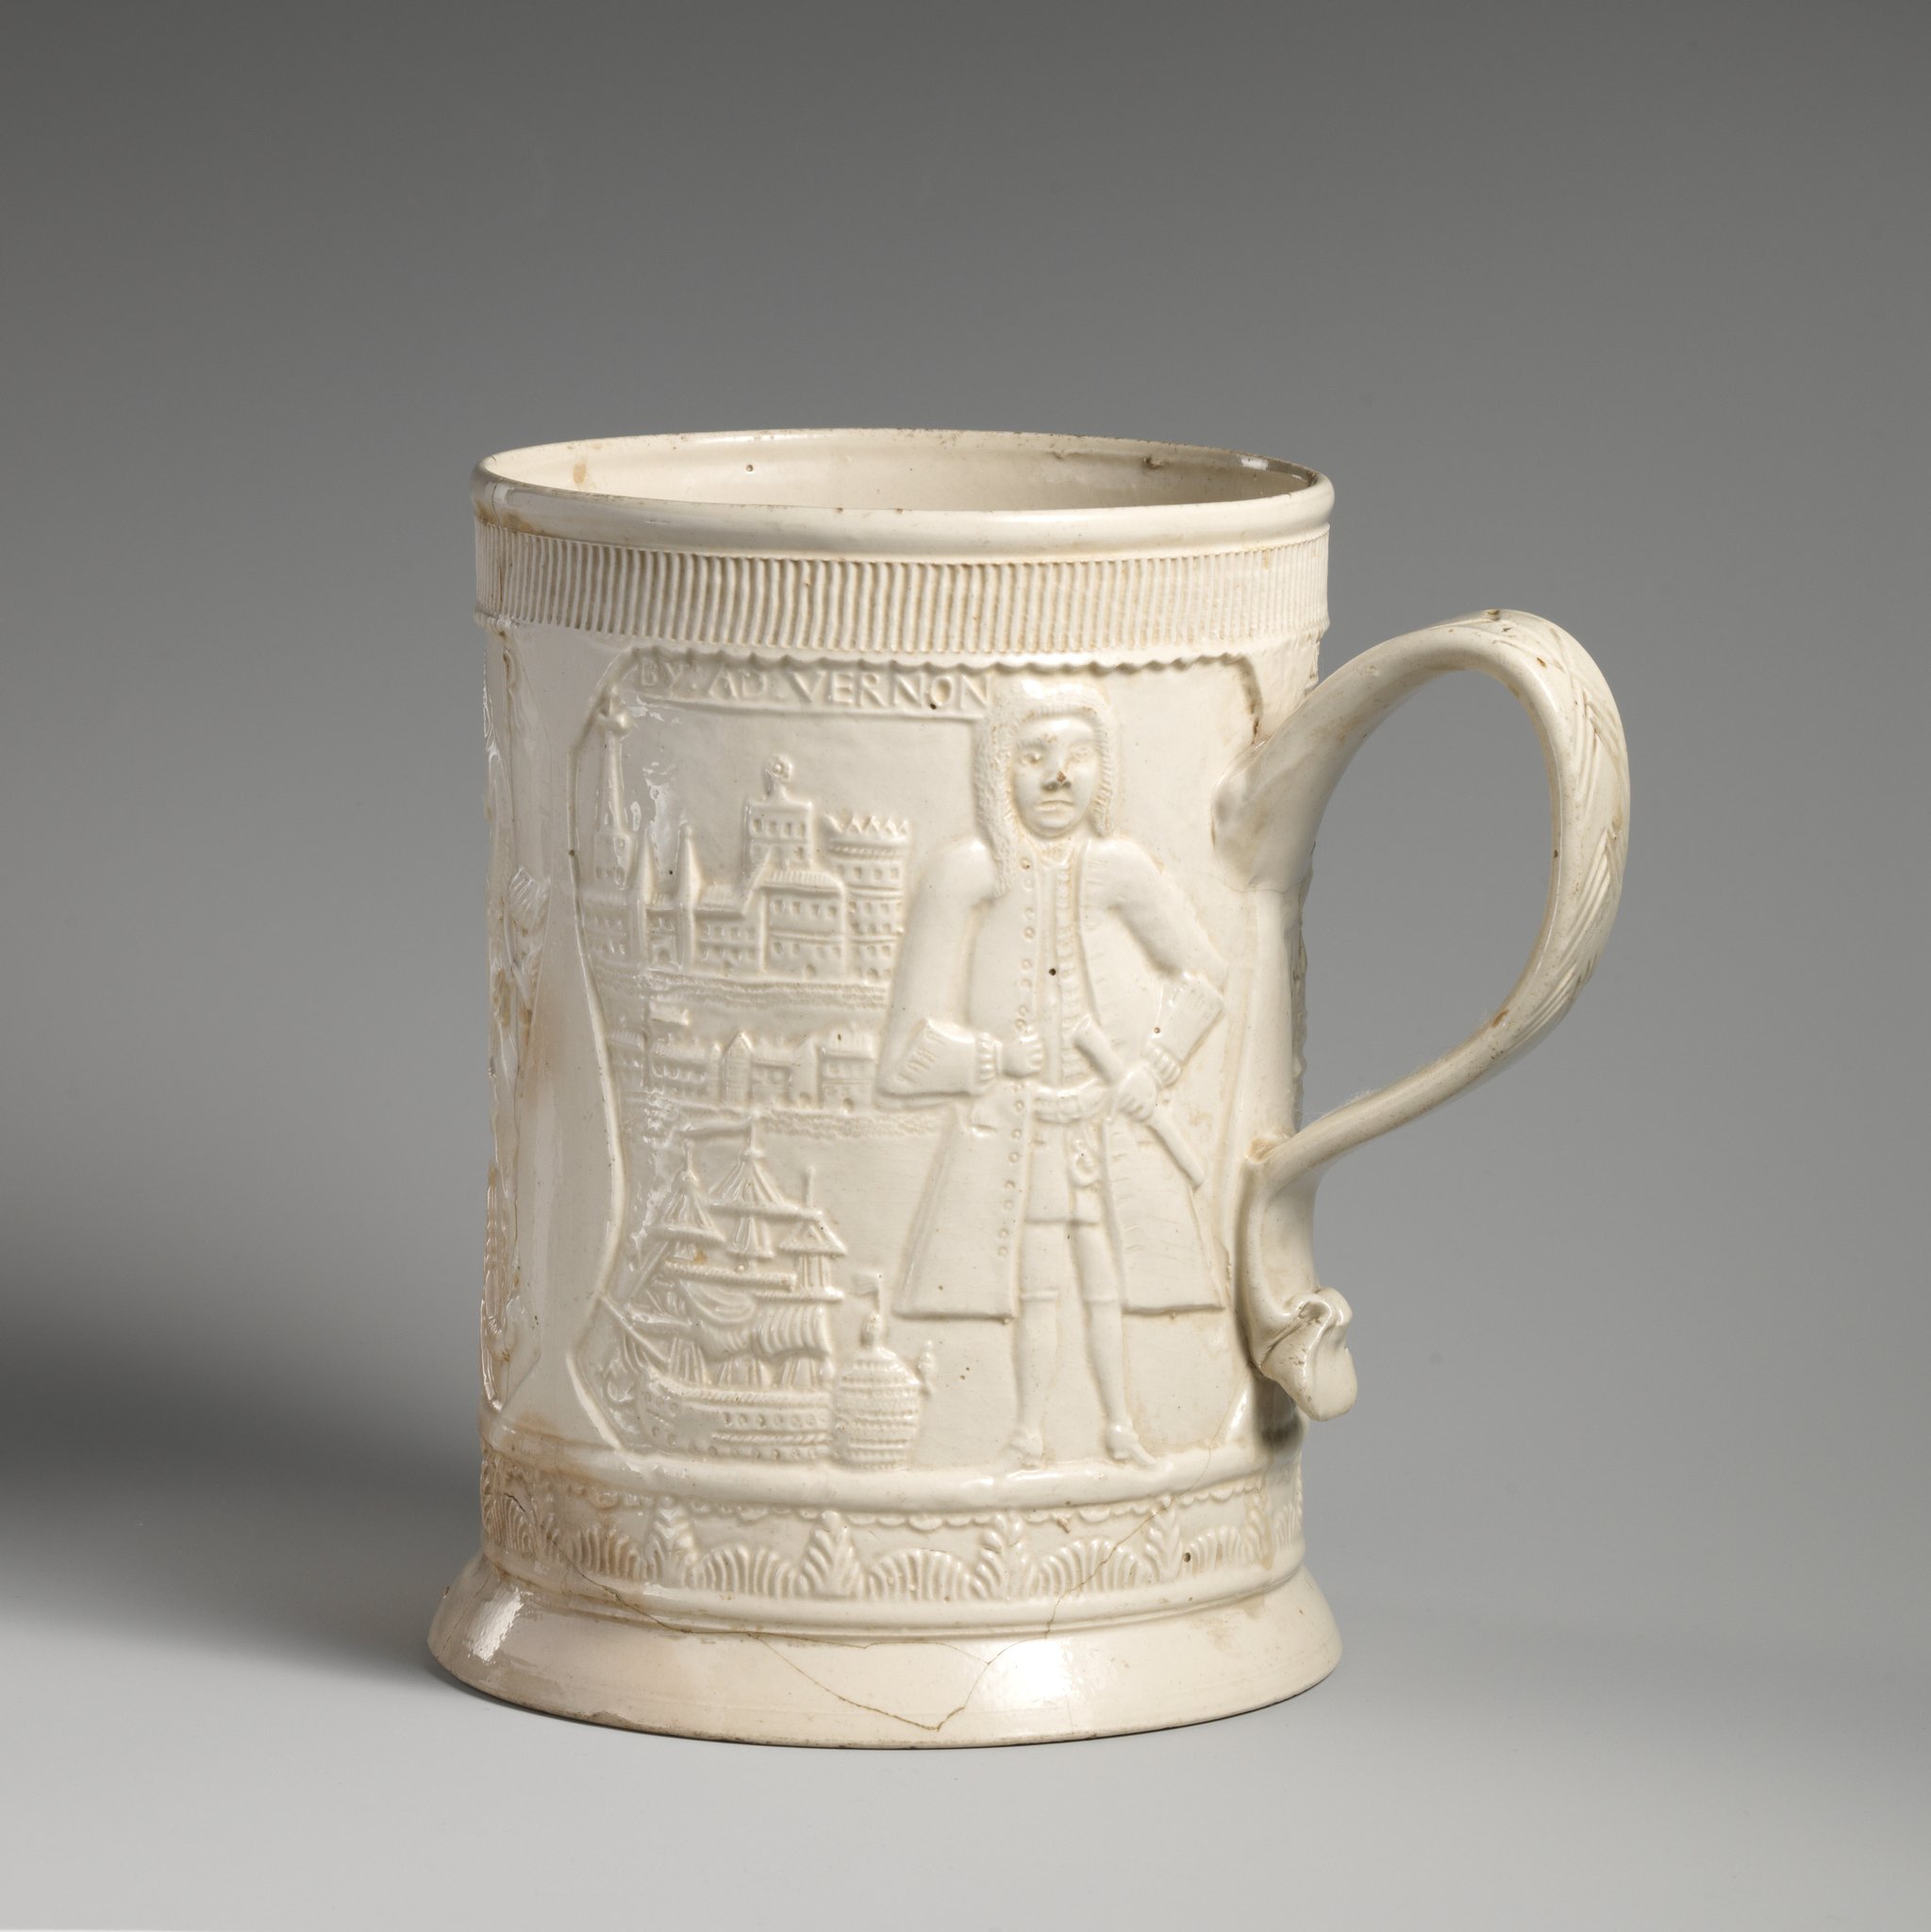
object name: mug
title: Mug with Admiral Edward Vernon (1684–1757) and the capture of Porto Bello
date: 1739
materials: stoneware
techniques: salt glaze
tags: lions,coat of arms